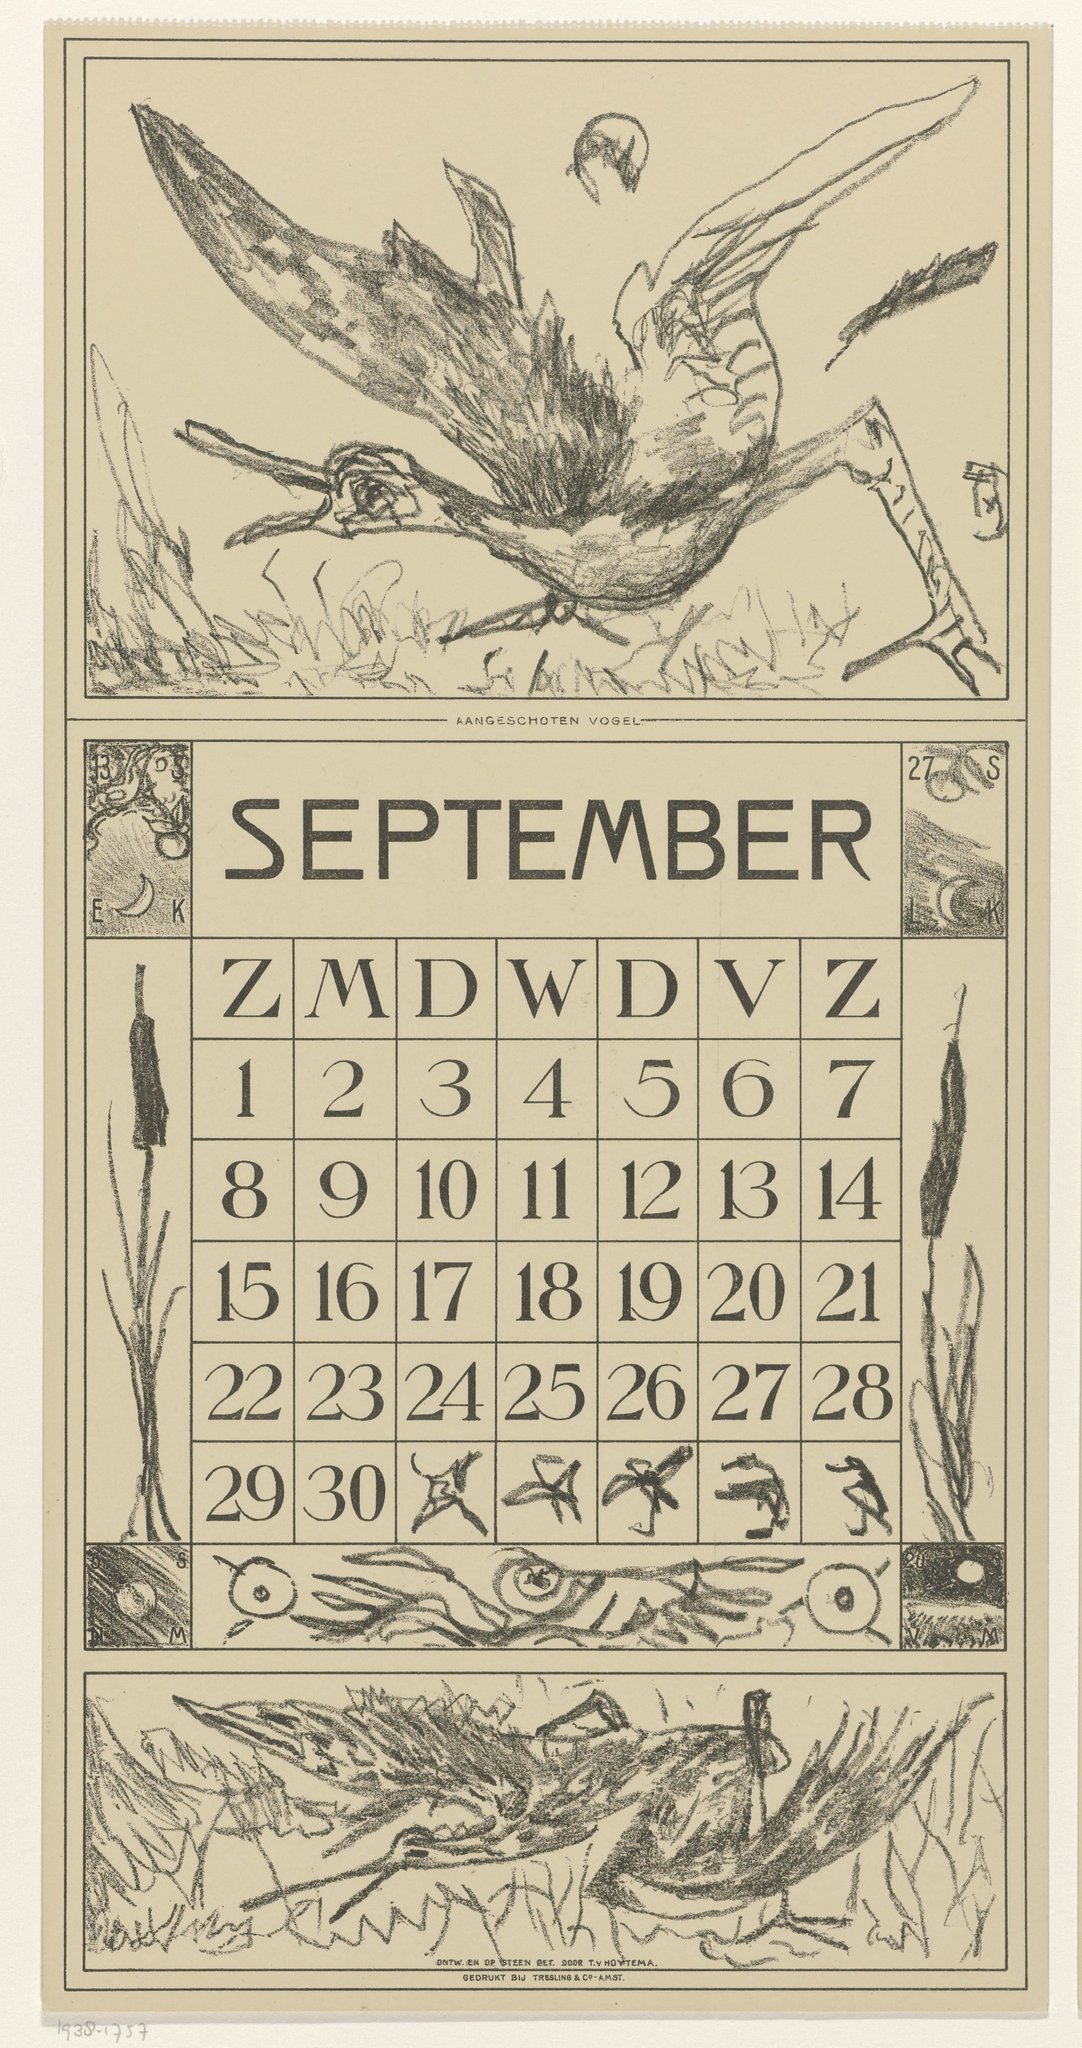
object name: calendar leaf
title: Kalender 1918 12 lithografien door Th. v. Hoytema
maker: theo van hoytema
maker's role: draughtsman, painter, print maker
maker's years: 1863-1917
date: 1917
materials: paper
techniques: lithograph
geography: amsterdam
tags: birds (+ animal killed by man), lunar year, birds (+ animal(s) being wounded), plants and herbs: reed, september ~ other concepts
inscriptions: collector's mark: Lugt 2228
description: Links en rechts van het calendarium twee grote lisdoddes. In de hoeken de standen van de maan op vier dagen. Bovenaan het blad een scheurlijn.